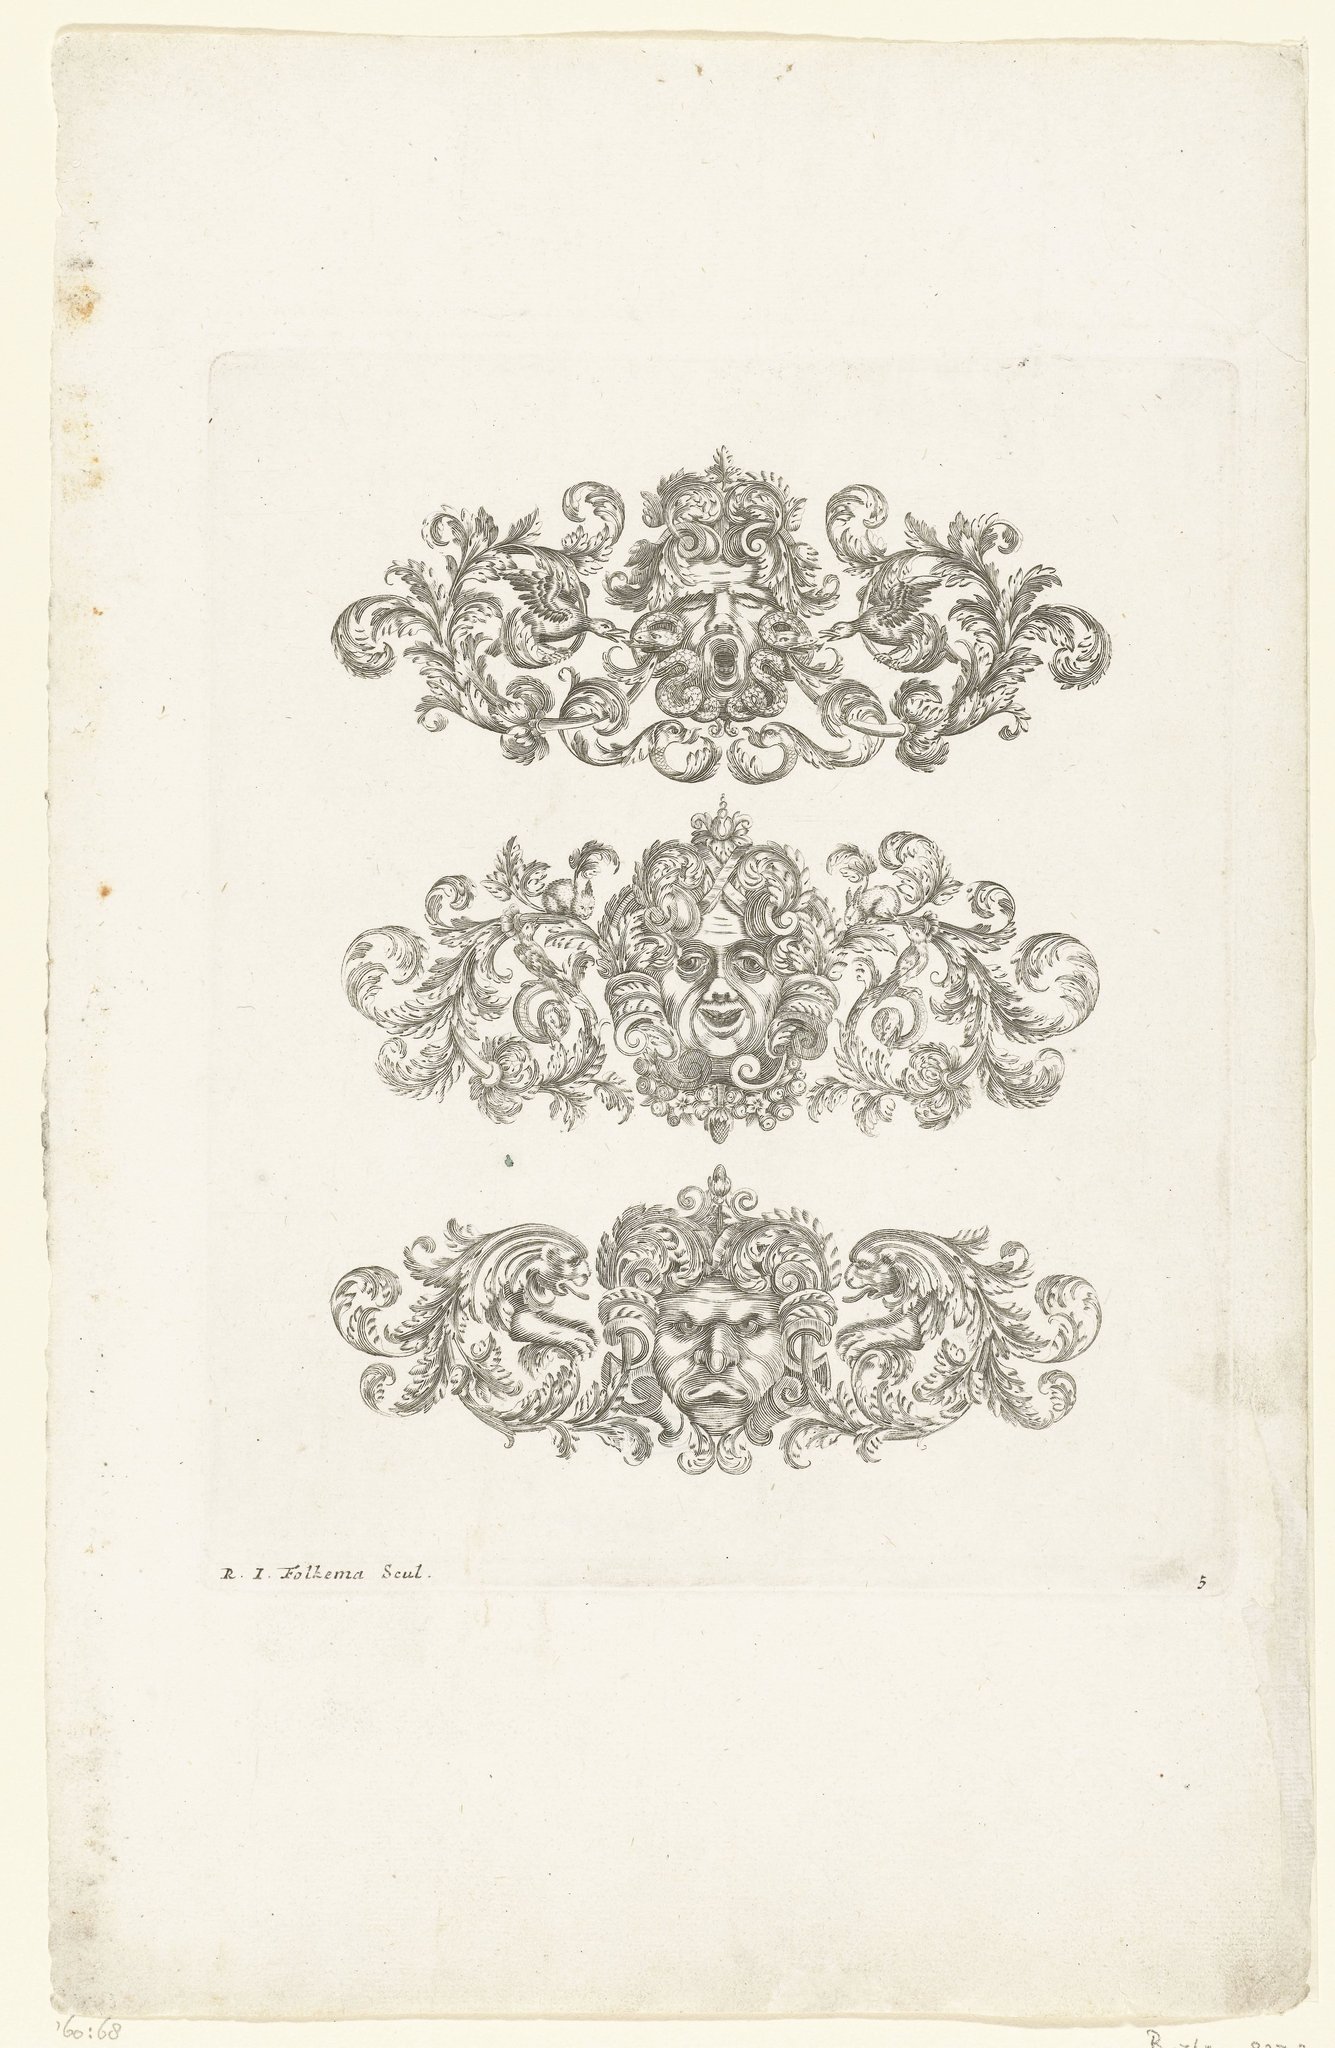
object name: ornament print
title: Drie maskers tussen bladranken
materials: paper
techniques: engraving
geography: amsterdam